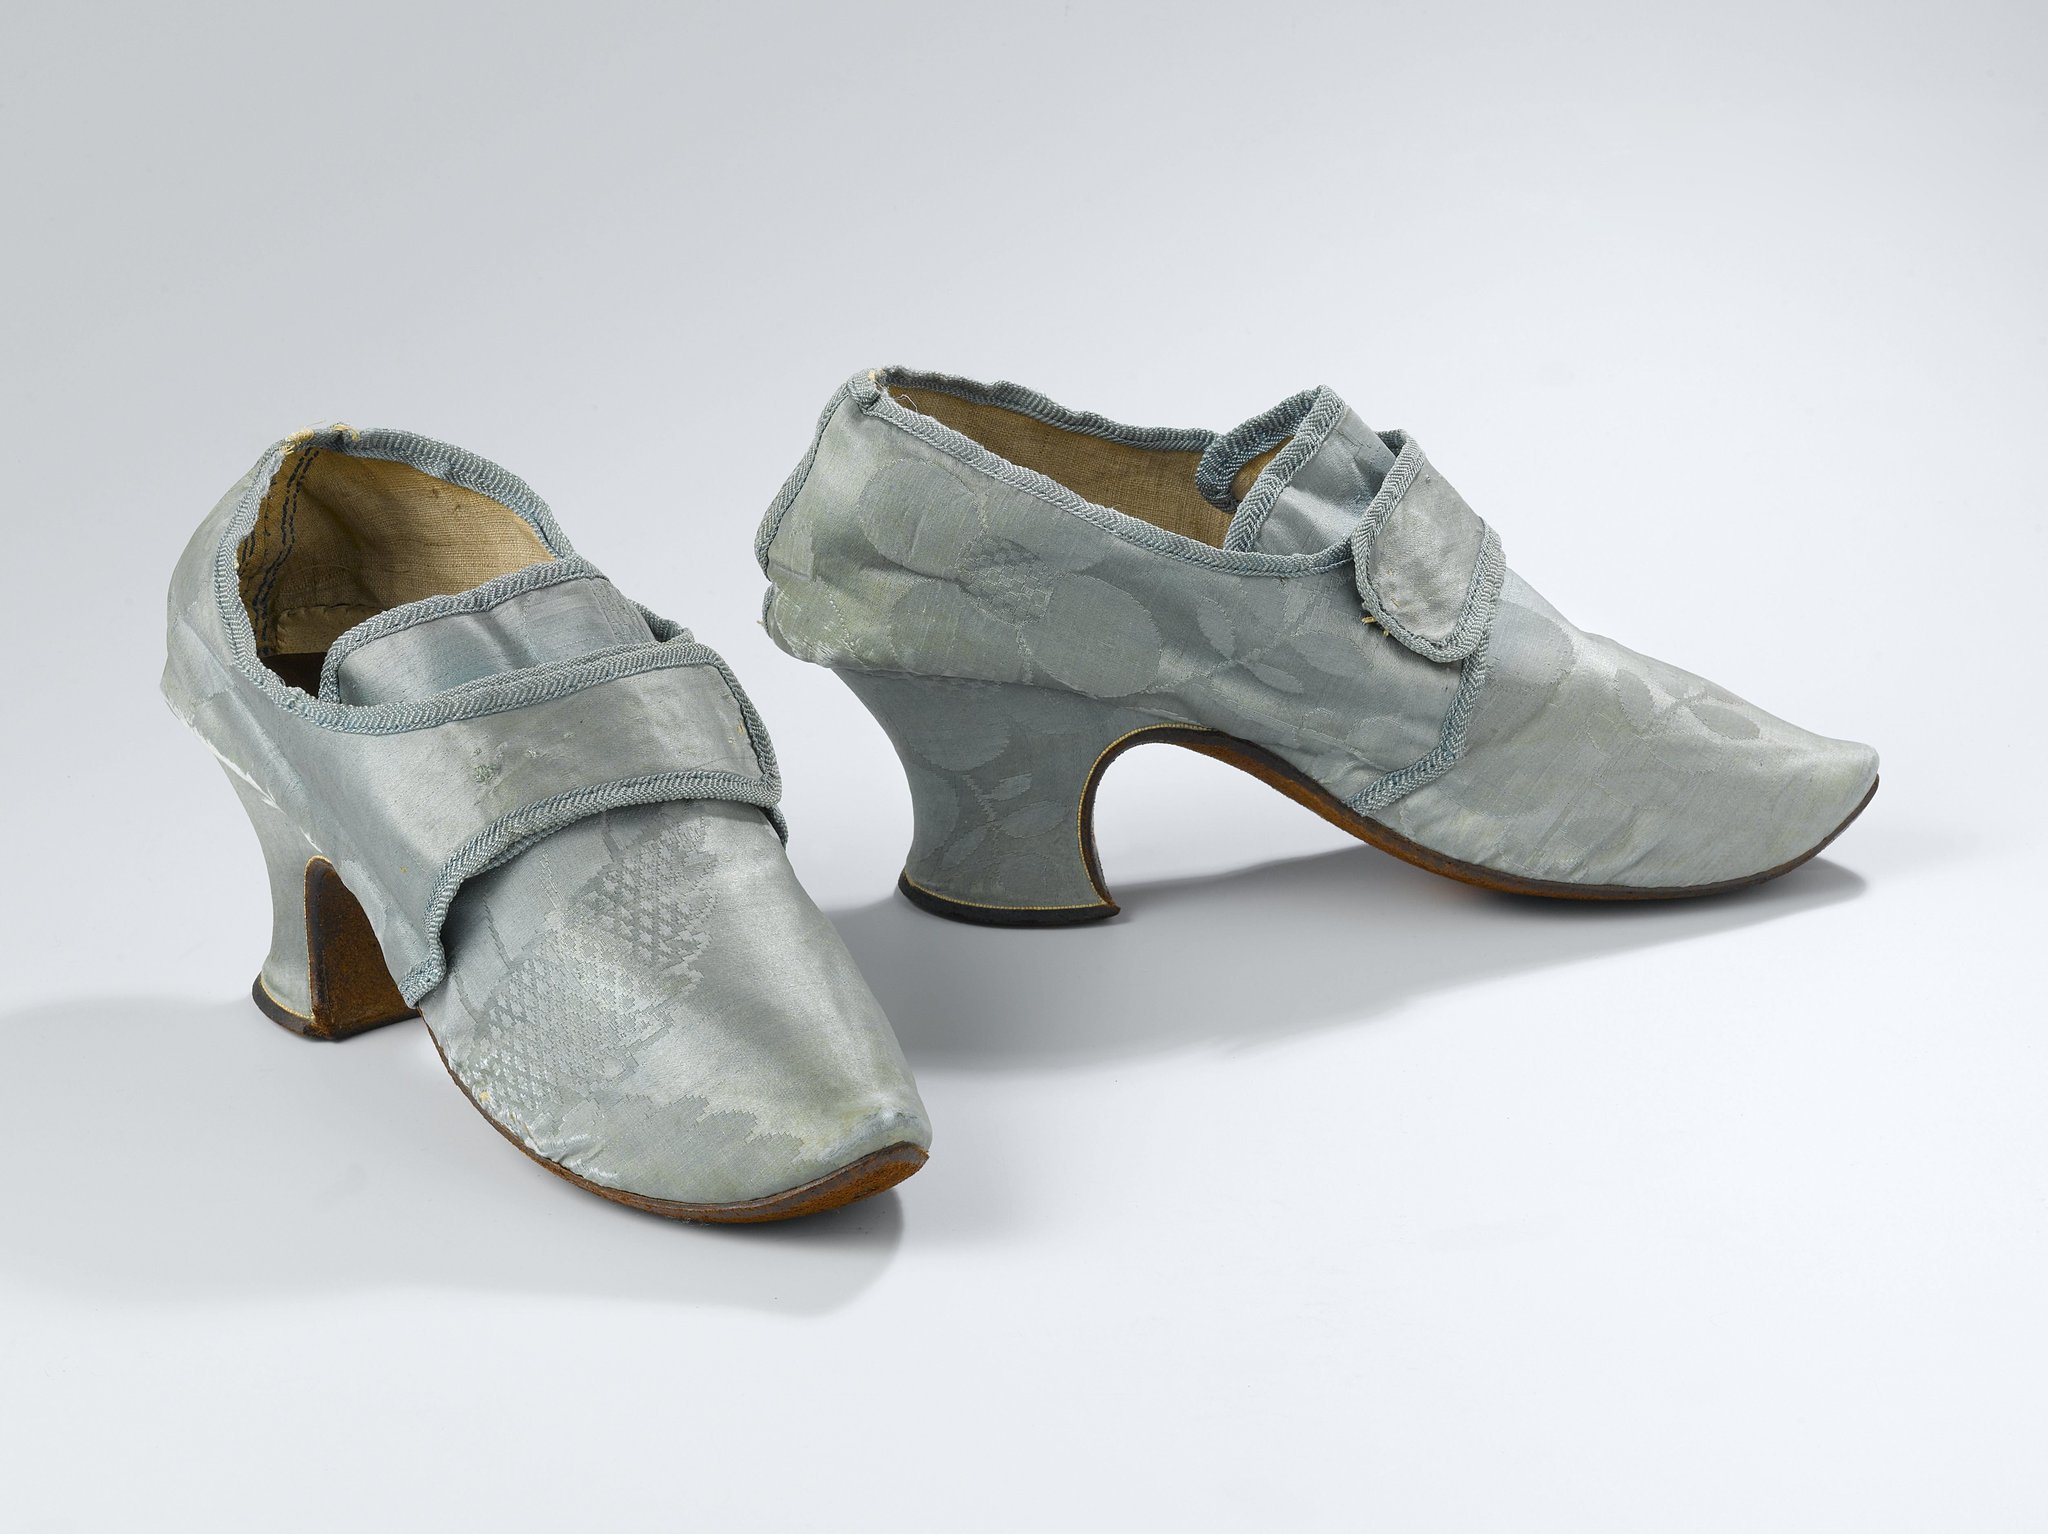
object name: shoe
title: Damesschoen van lichtblauw zijden damast met twee flappen over de wreef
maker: Anonymous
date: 1725-1750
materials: leather, linen, metal, silk, wood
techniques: tanning, weave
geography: france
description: Damesschoen van lichtblauw zijden damast. Model: Spitse opwippende neus, één voorblad en twee zijbladen. Op de stiksels, die de bladen bij elkaar houden, een band ripszijde. Vierkante tong op de wreef. Over de tong lopen vanaf de zijbladen twee flappen over elkaar. De rechterflap heeft een ijzeren haakje die je kan vasthaken aan een lus op de linkerflap. De voorkant van de hak loopt in een afgeronde hoek vanaf het geleng iets getailleerd naar beneden. De zijkant en achterkant van de hak zijn iets getailleerd en bekleed met lichtblauw zijde.. Langs de rand van de hak lopen witte stiksels. De hak heeft een donkerbruine rand leer van het achterlapje. Zijbladen en voorblad gevoerd met beige linnen. Aan de onderkant van de zijbladen en het voorblad aansluitend aan de binnenzool is een reep ivoorwit leer bevestigd waarschijnlijk ter versteviging van de schoen. De binnenzool is van donkerbruin leer. Geruwd leren achterlapje met vier houten spijkers aan de hak vastgeslagen en geruwd leren zool. Versiering: In de tekening van het damast zijn bloemen en bladeren te zien. Afgebiesd met lichtblauw ripsband. Geen links/rechts verschil.